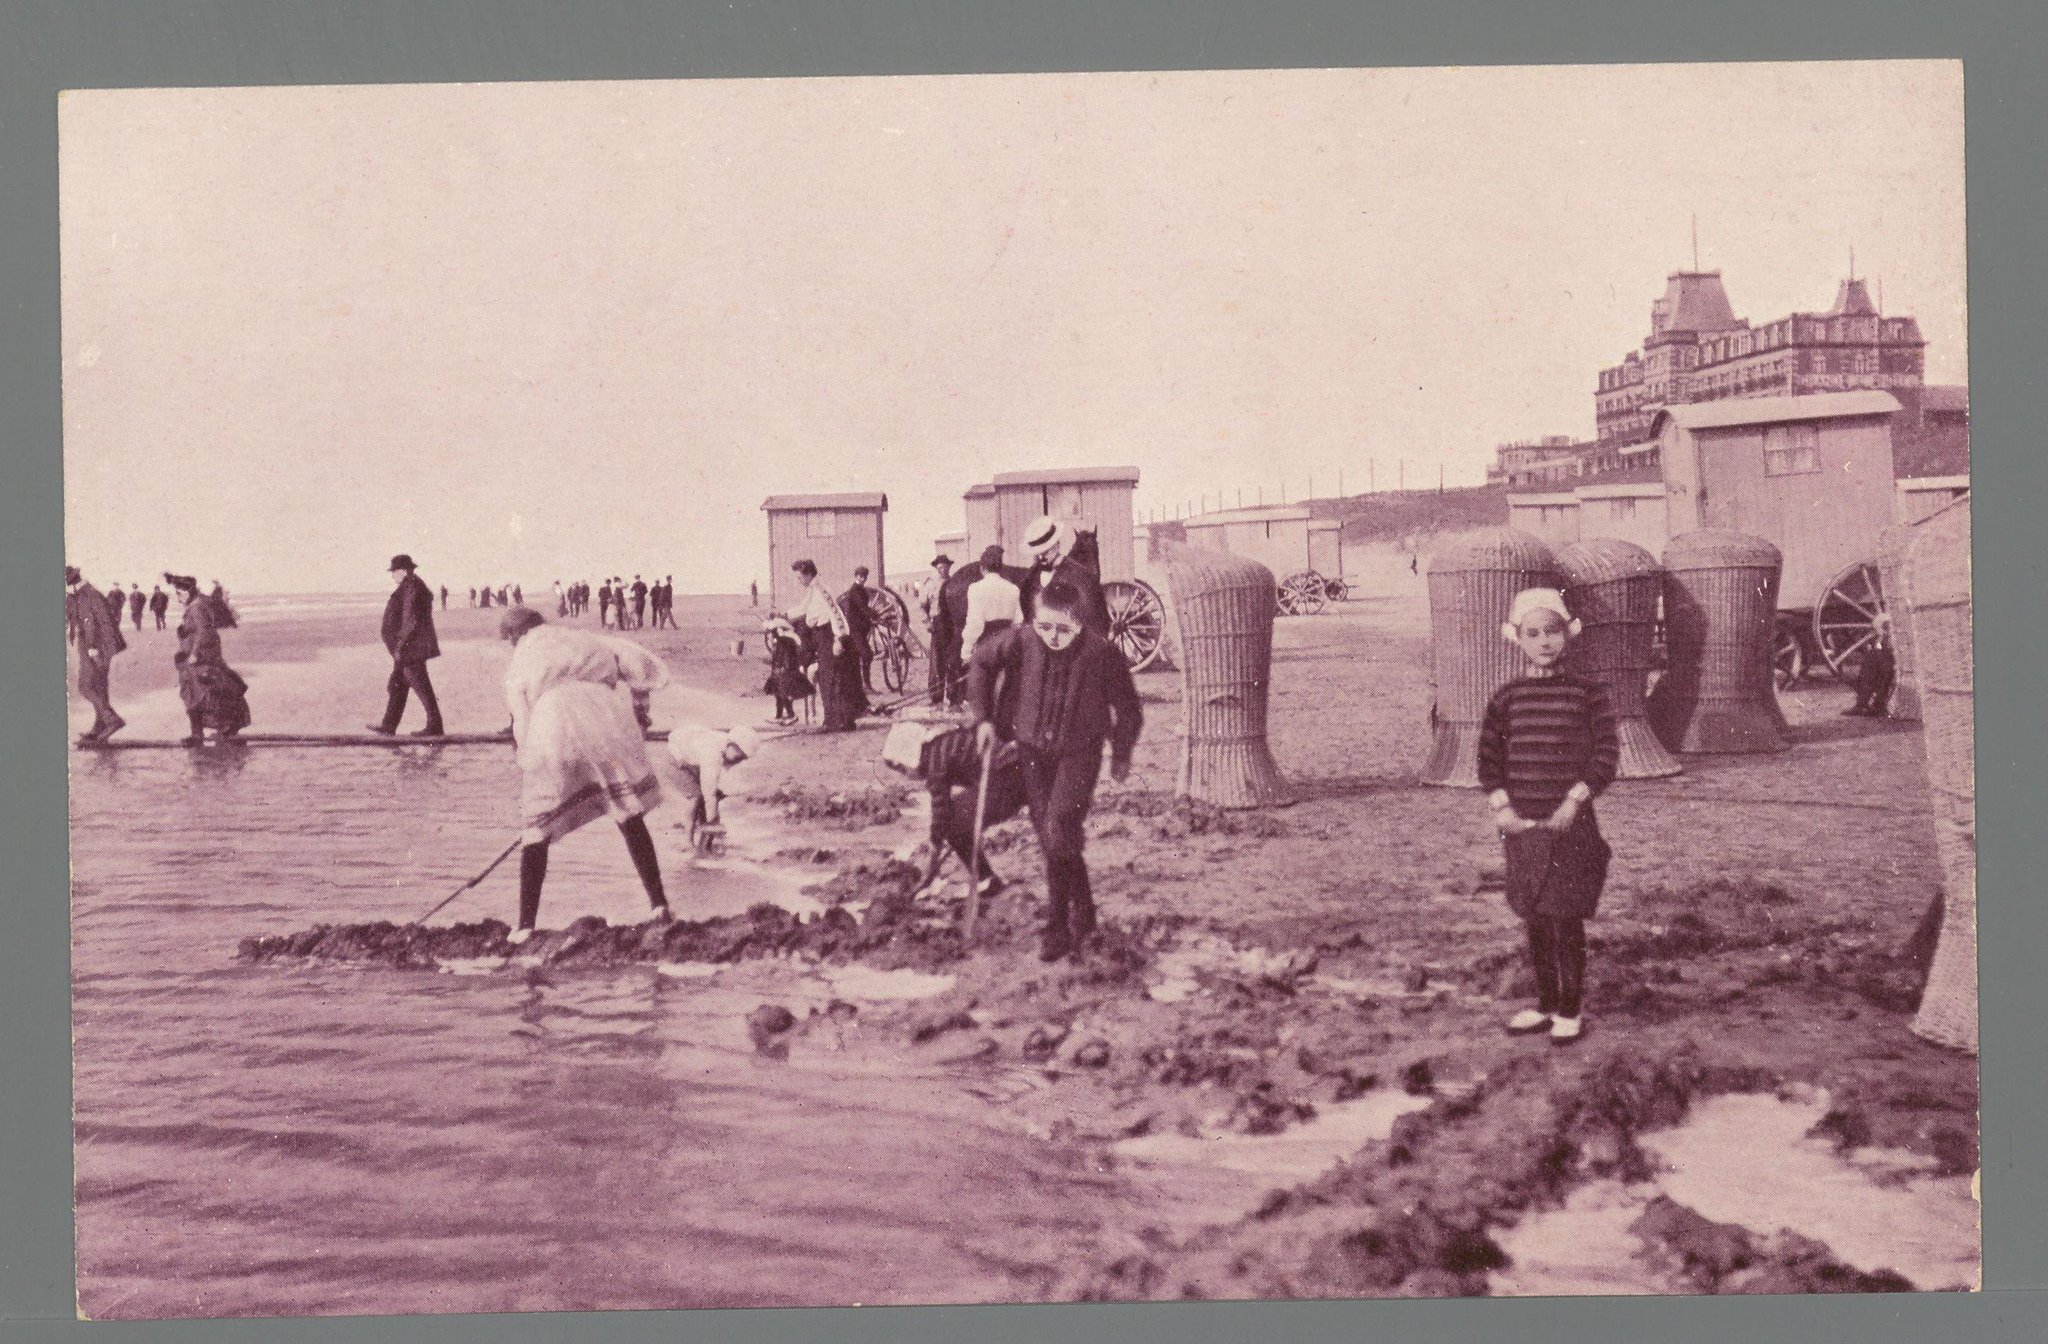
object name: photomechanical print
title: Zandvoort. Strandgezicht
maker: Anonymous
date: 1906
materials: cardboard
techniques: autotype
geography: zandvoort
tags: beach (as place of recreation), recreation, sea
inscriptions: date